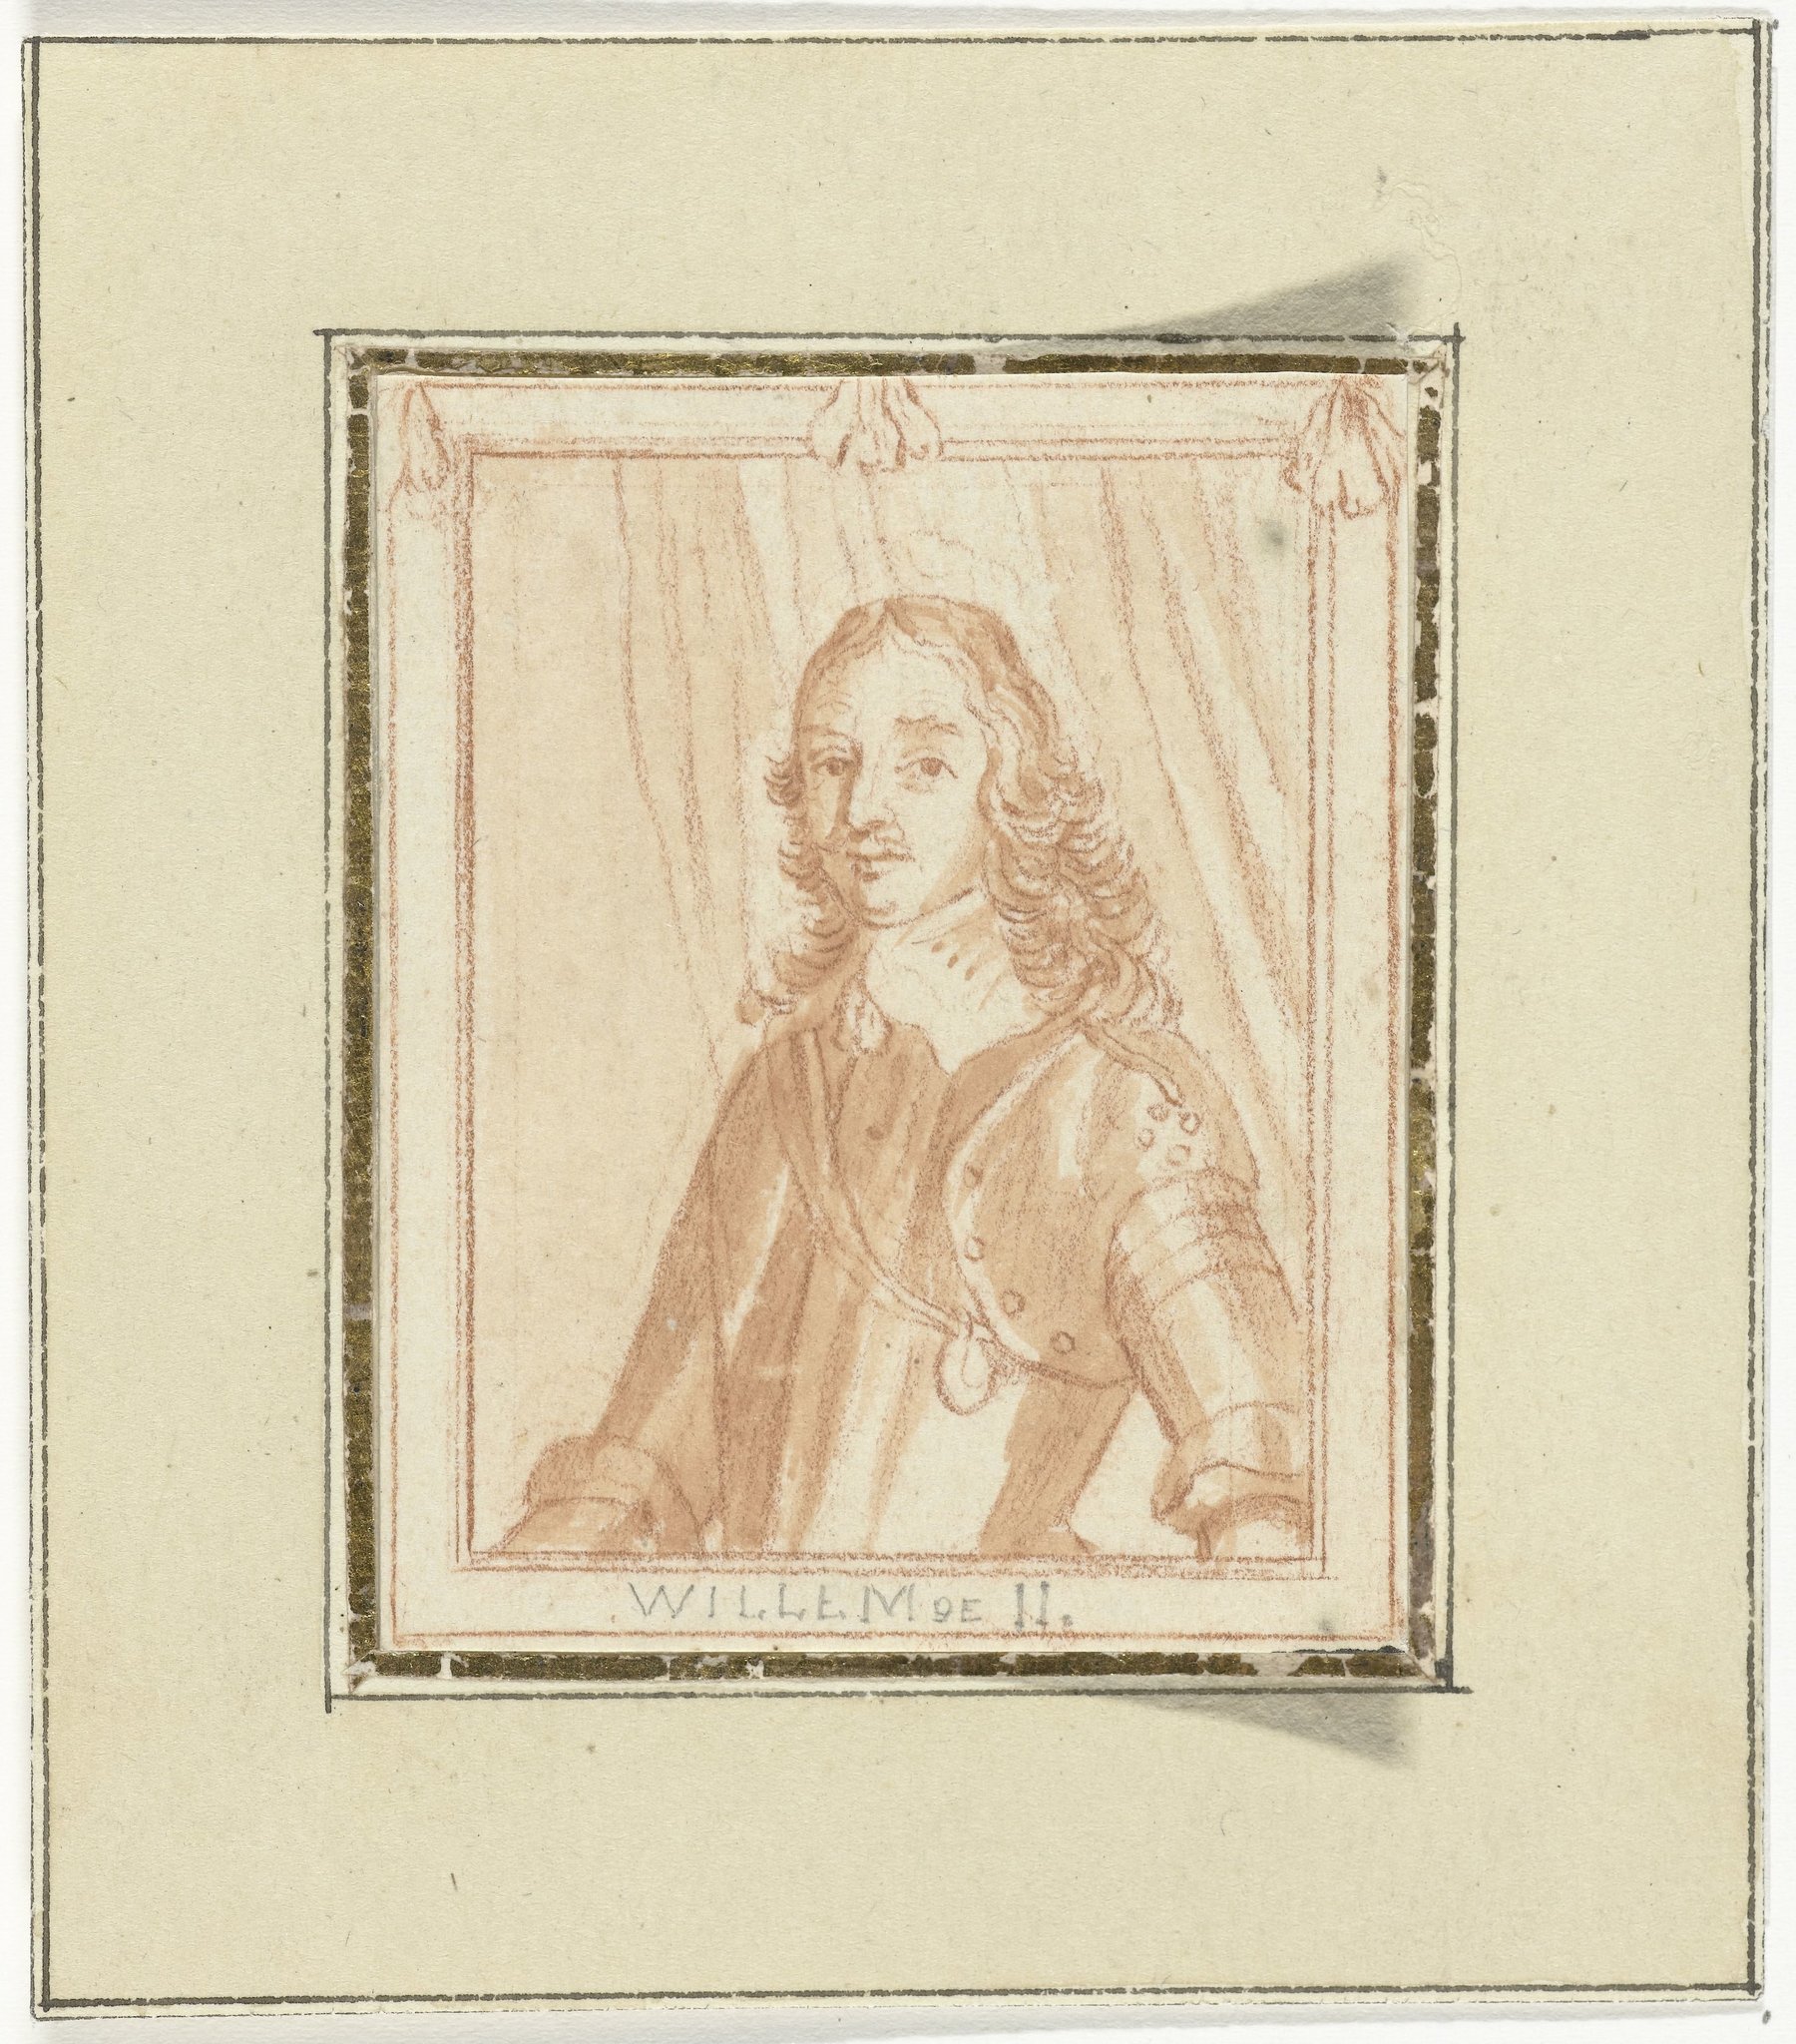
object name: drawing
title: Portret van Willem II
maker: Anonymous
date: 1683-1783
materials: chalk, paper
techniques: brush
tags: william ii (prince of orange), historical persons